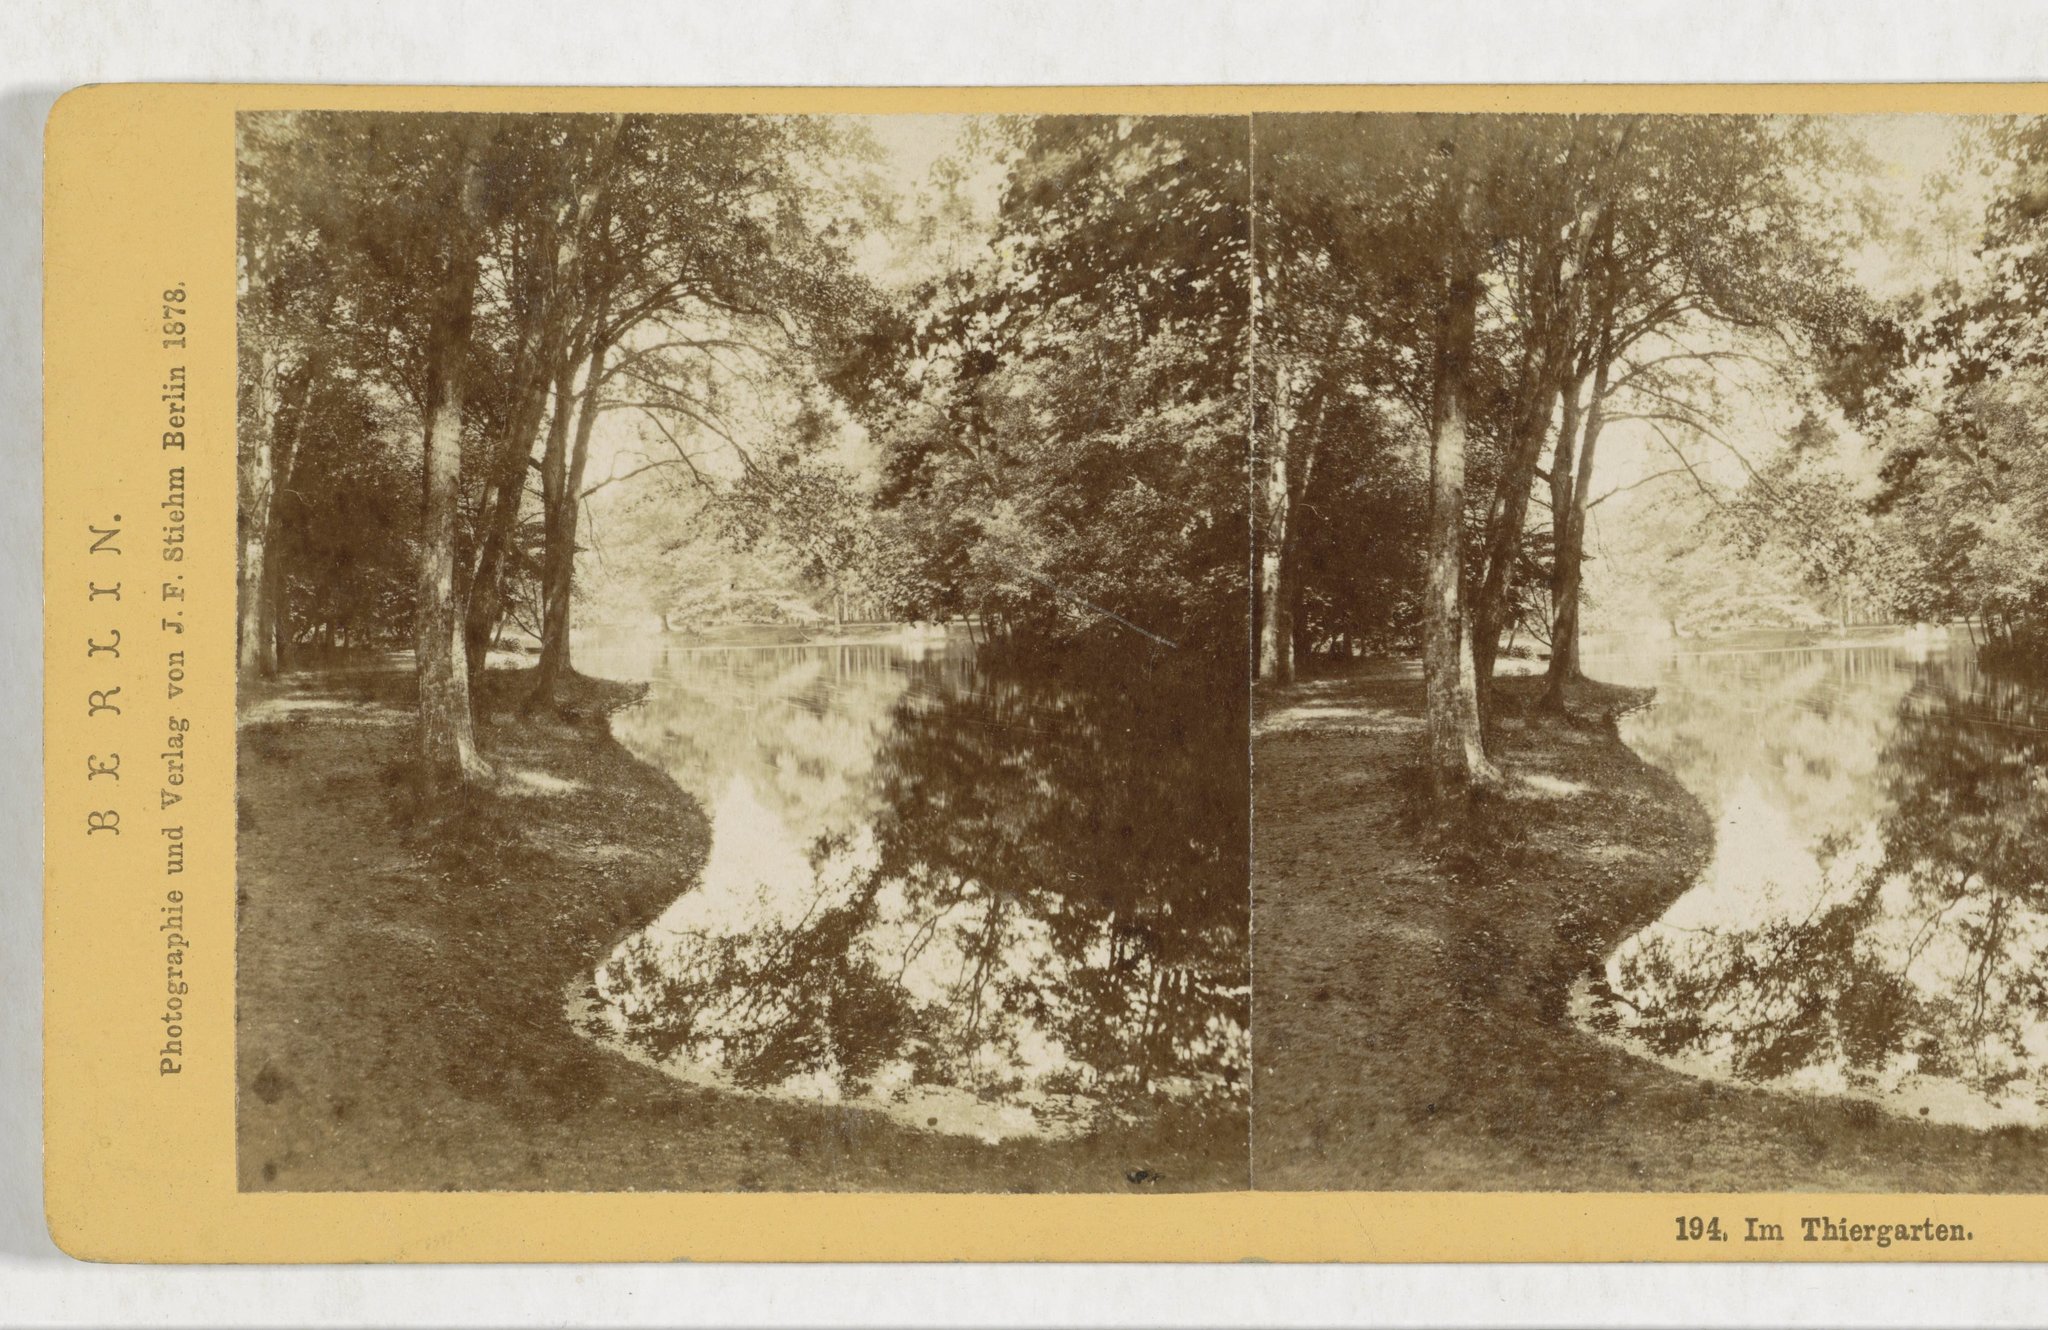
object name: stereograph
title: Bomen bij een vijver in de Tiergarten, Berlijn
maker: johann friedrich stiehm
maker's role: fotograaf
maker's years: 1826-1902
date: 1878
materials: cardboard, paper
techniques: albumen print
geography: berlin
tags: park, public gardens, park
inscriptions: number: ‘194.’